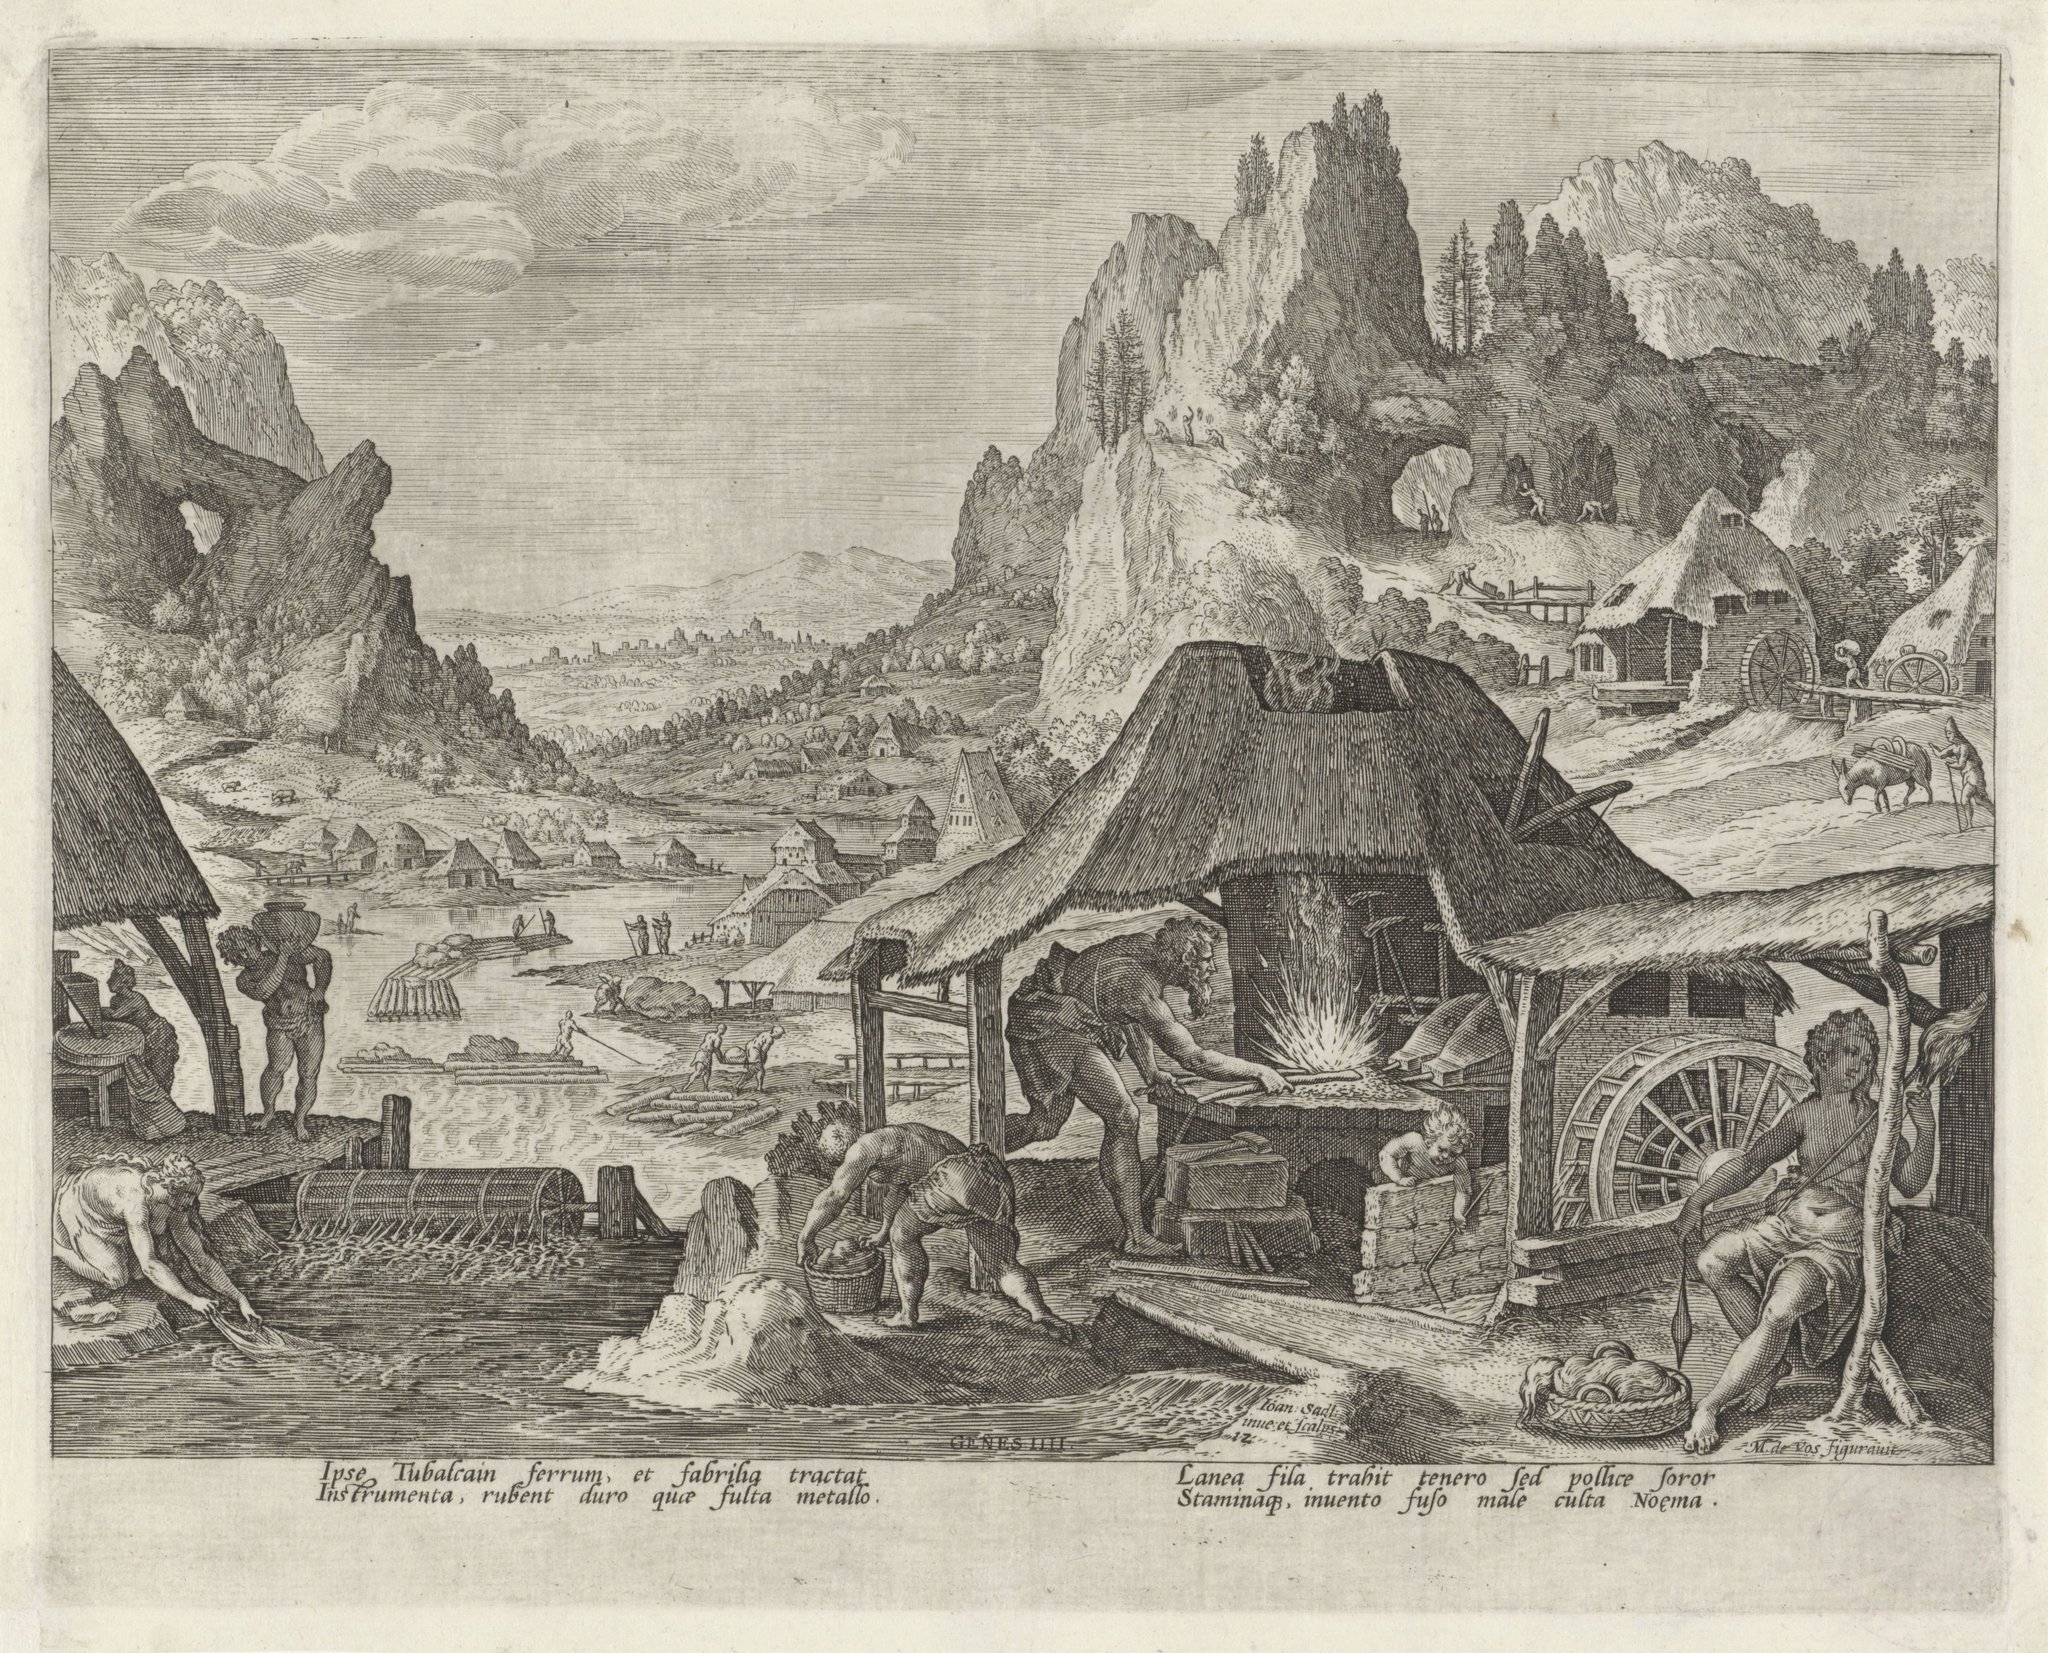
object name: print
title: Boni et mali scientia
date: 1583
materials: paper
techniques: engraving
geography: antwerp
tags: story of tubalcain, the first blacksmith, smith, blacksmith, spinning (manufacture of yarn)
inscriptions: collector's mark: Lugt 240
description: Tubal-Kaïn in zijn smidse. Rechts zijn zus Naäma die garen spint. De prent heeft een Latijns onderschrift.